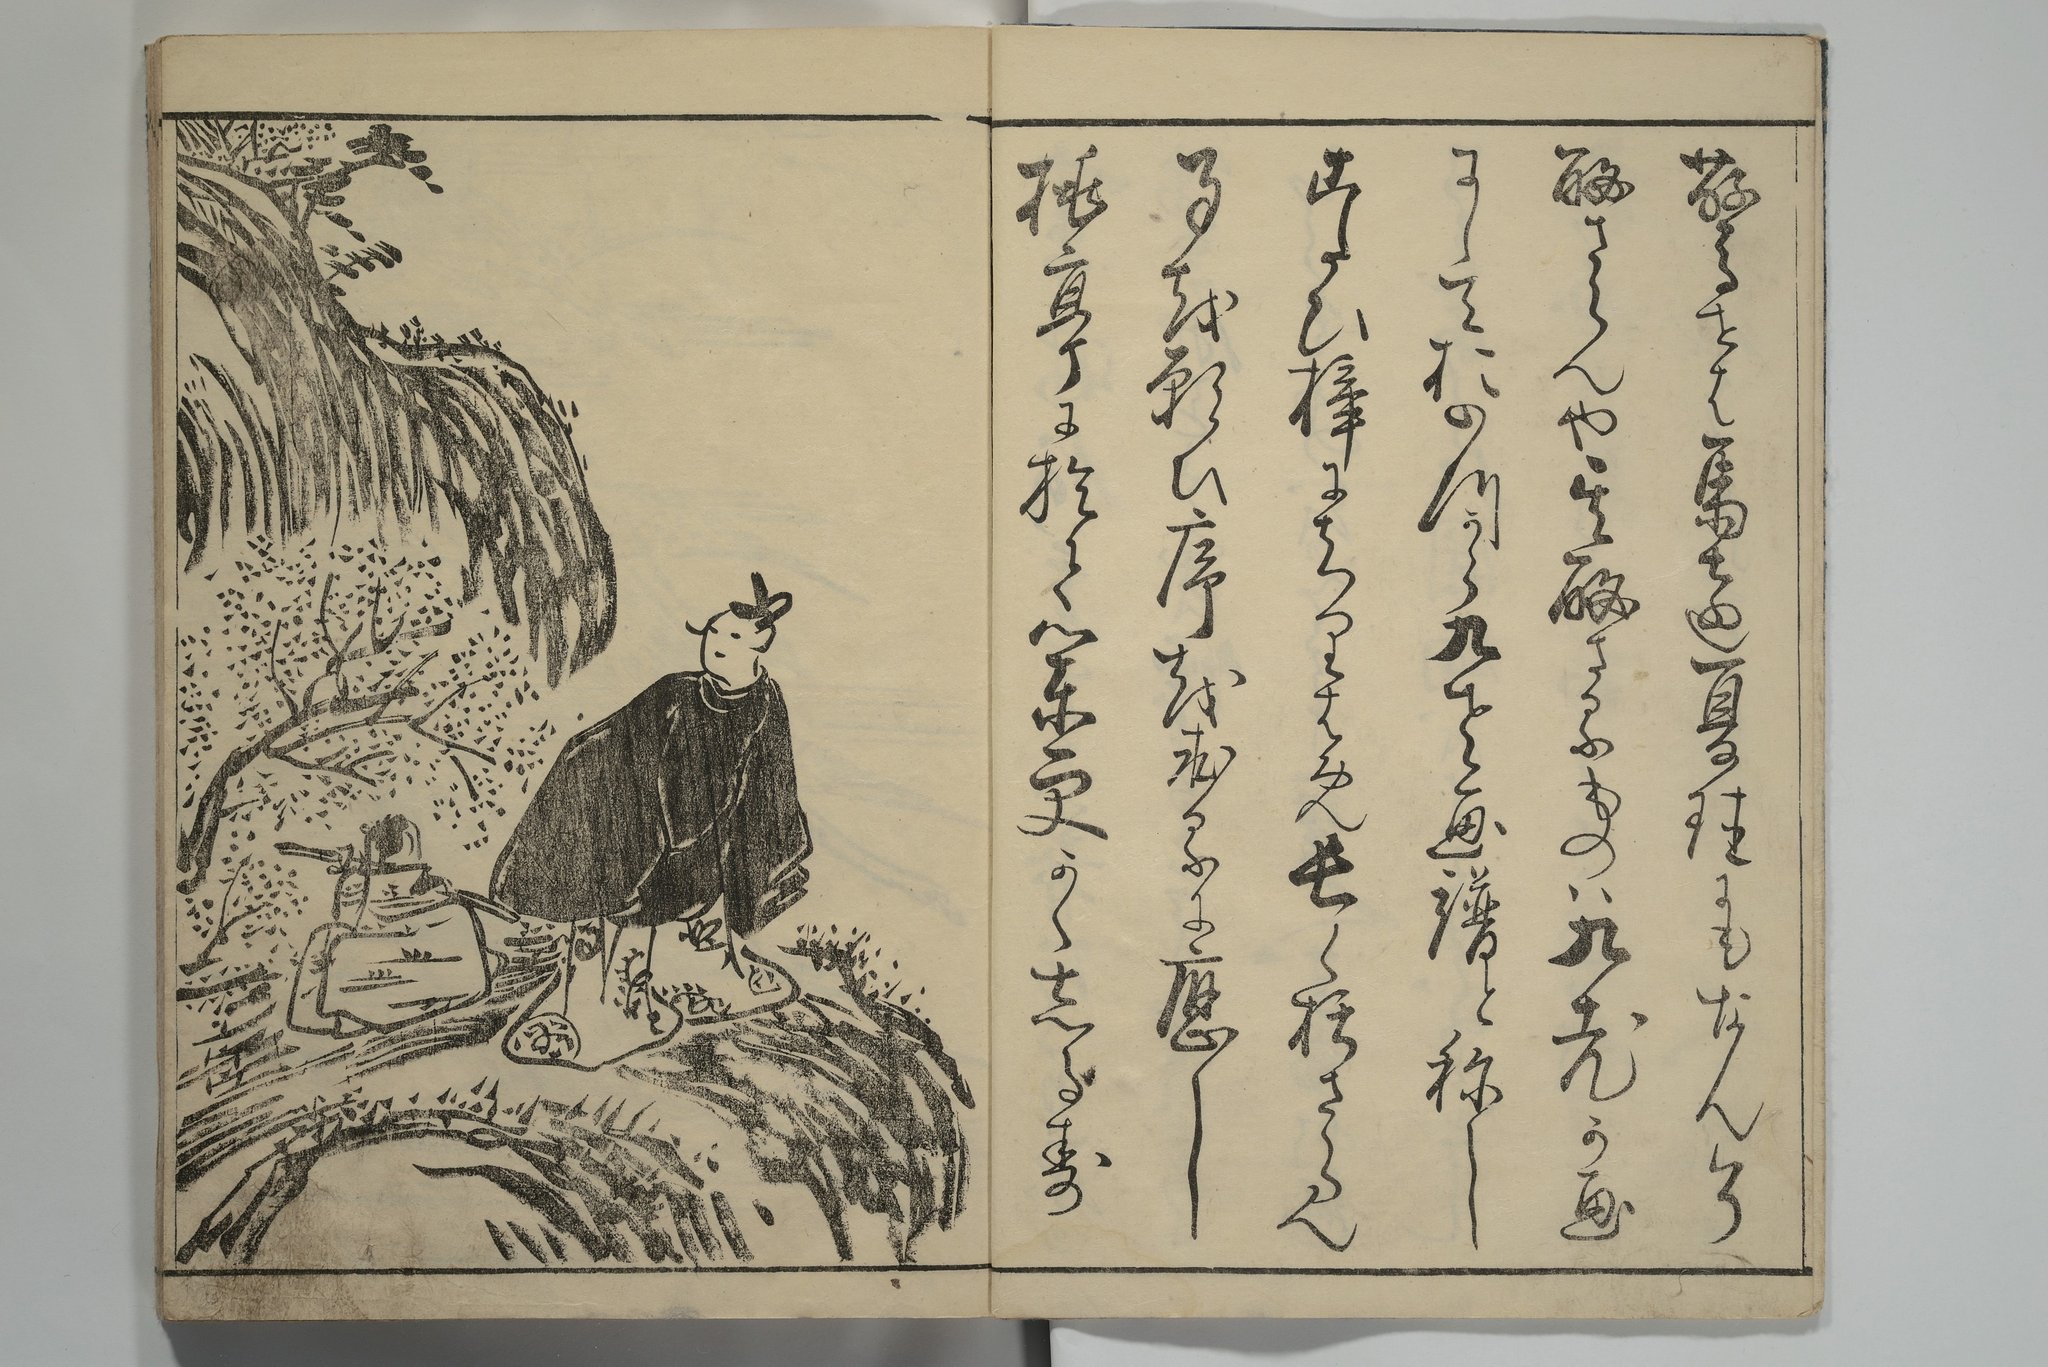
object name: illustrated book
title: Kyūrō (Baitei) Picture Album (Kyūrō gafu) 九老画譜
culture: japanese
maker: ki baitei 紀梅亭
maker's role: artist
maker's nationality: japanese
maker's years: 1734-1810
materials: ink, paper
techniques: woodblock print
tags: human figures